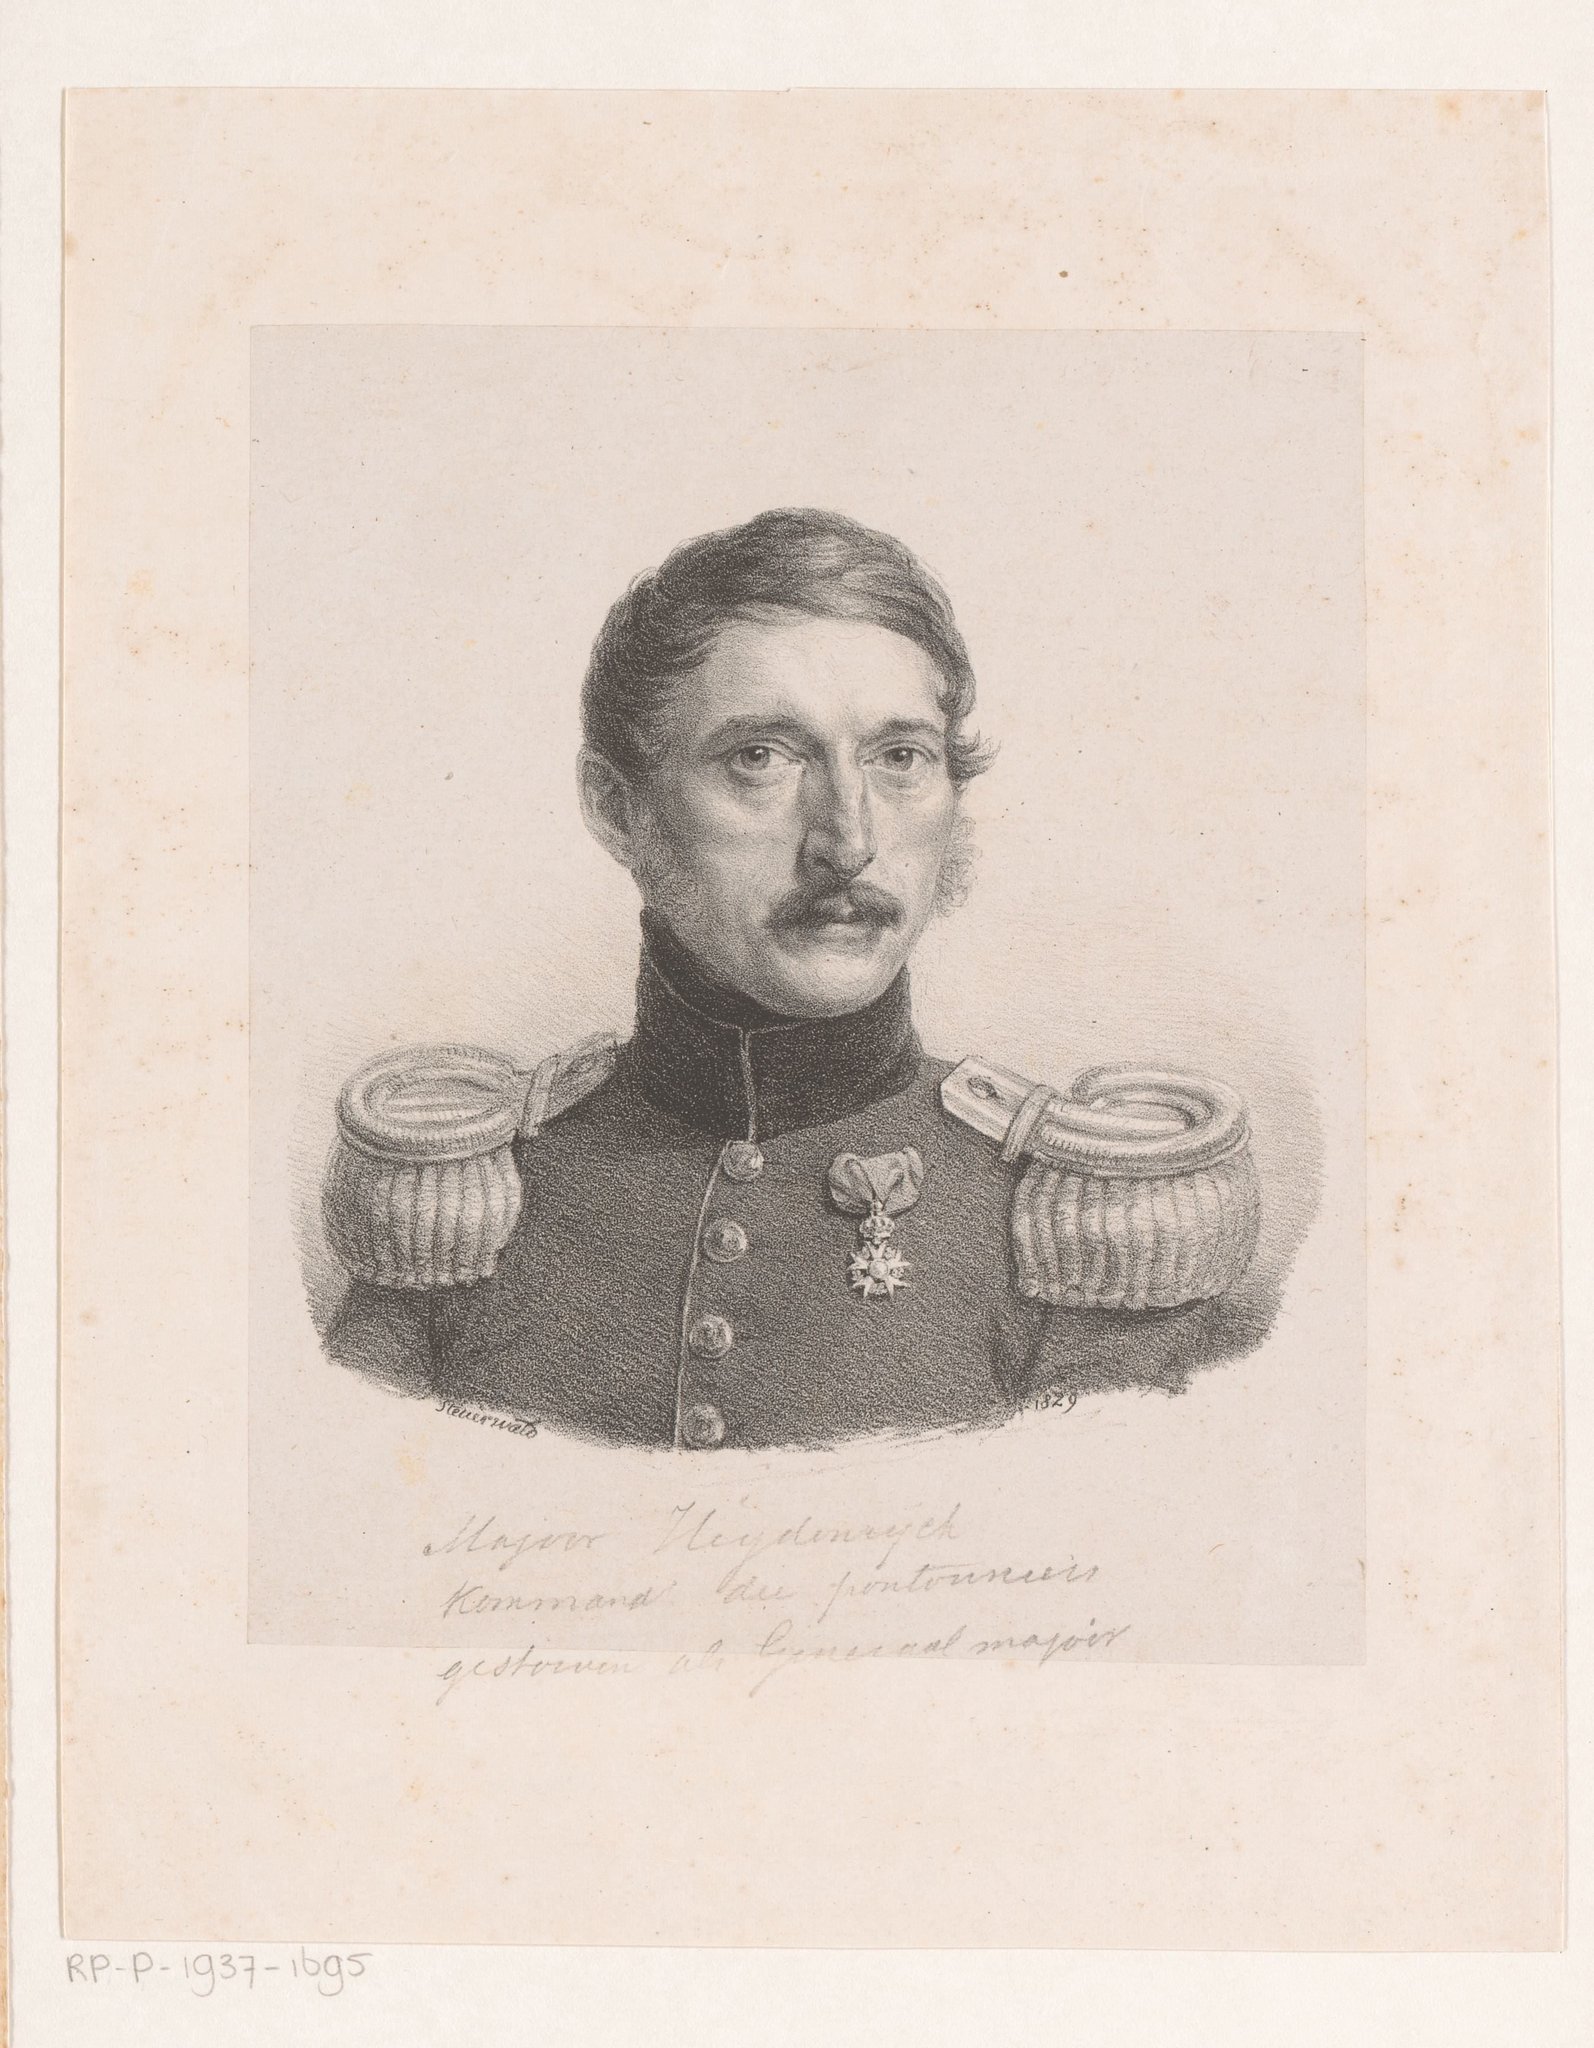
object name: print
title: Portret van kolonel kommandant Heydenreich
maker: christian heinrich gottlieb steuerwald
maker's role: draughtsman, print maker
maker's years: 1802-1874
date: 1829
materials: paper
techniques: lithograph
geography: dordrecht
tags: historical persons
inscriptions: collector's mark: Lugt 2760, collector's mark: Lugt 2228